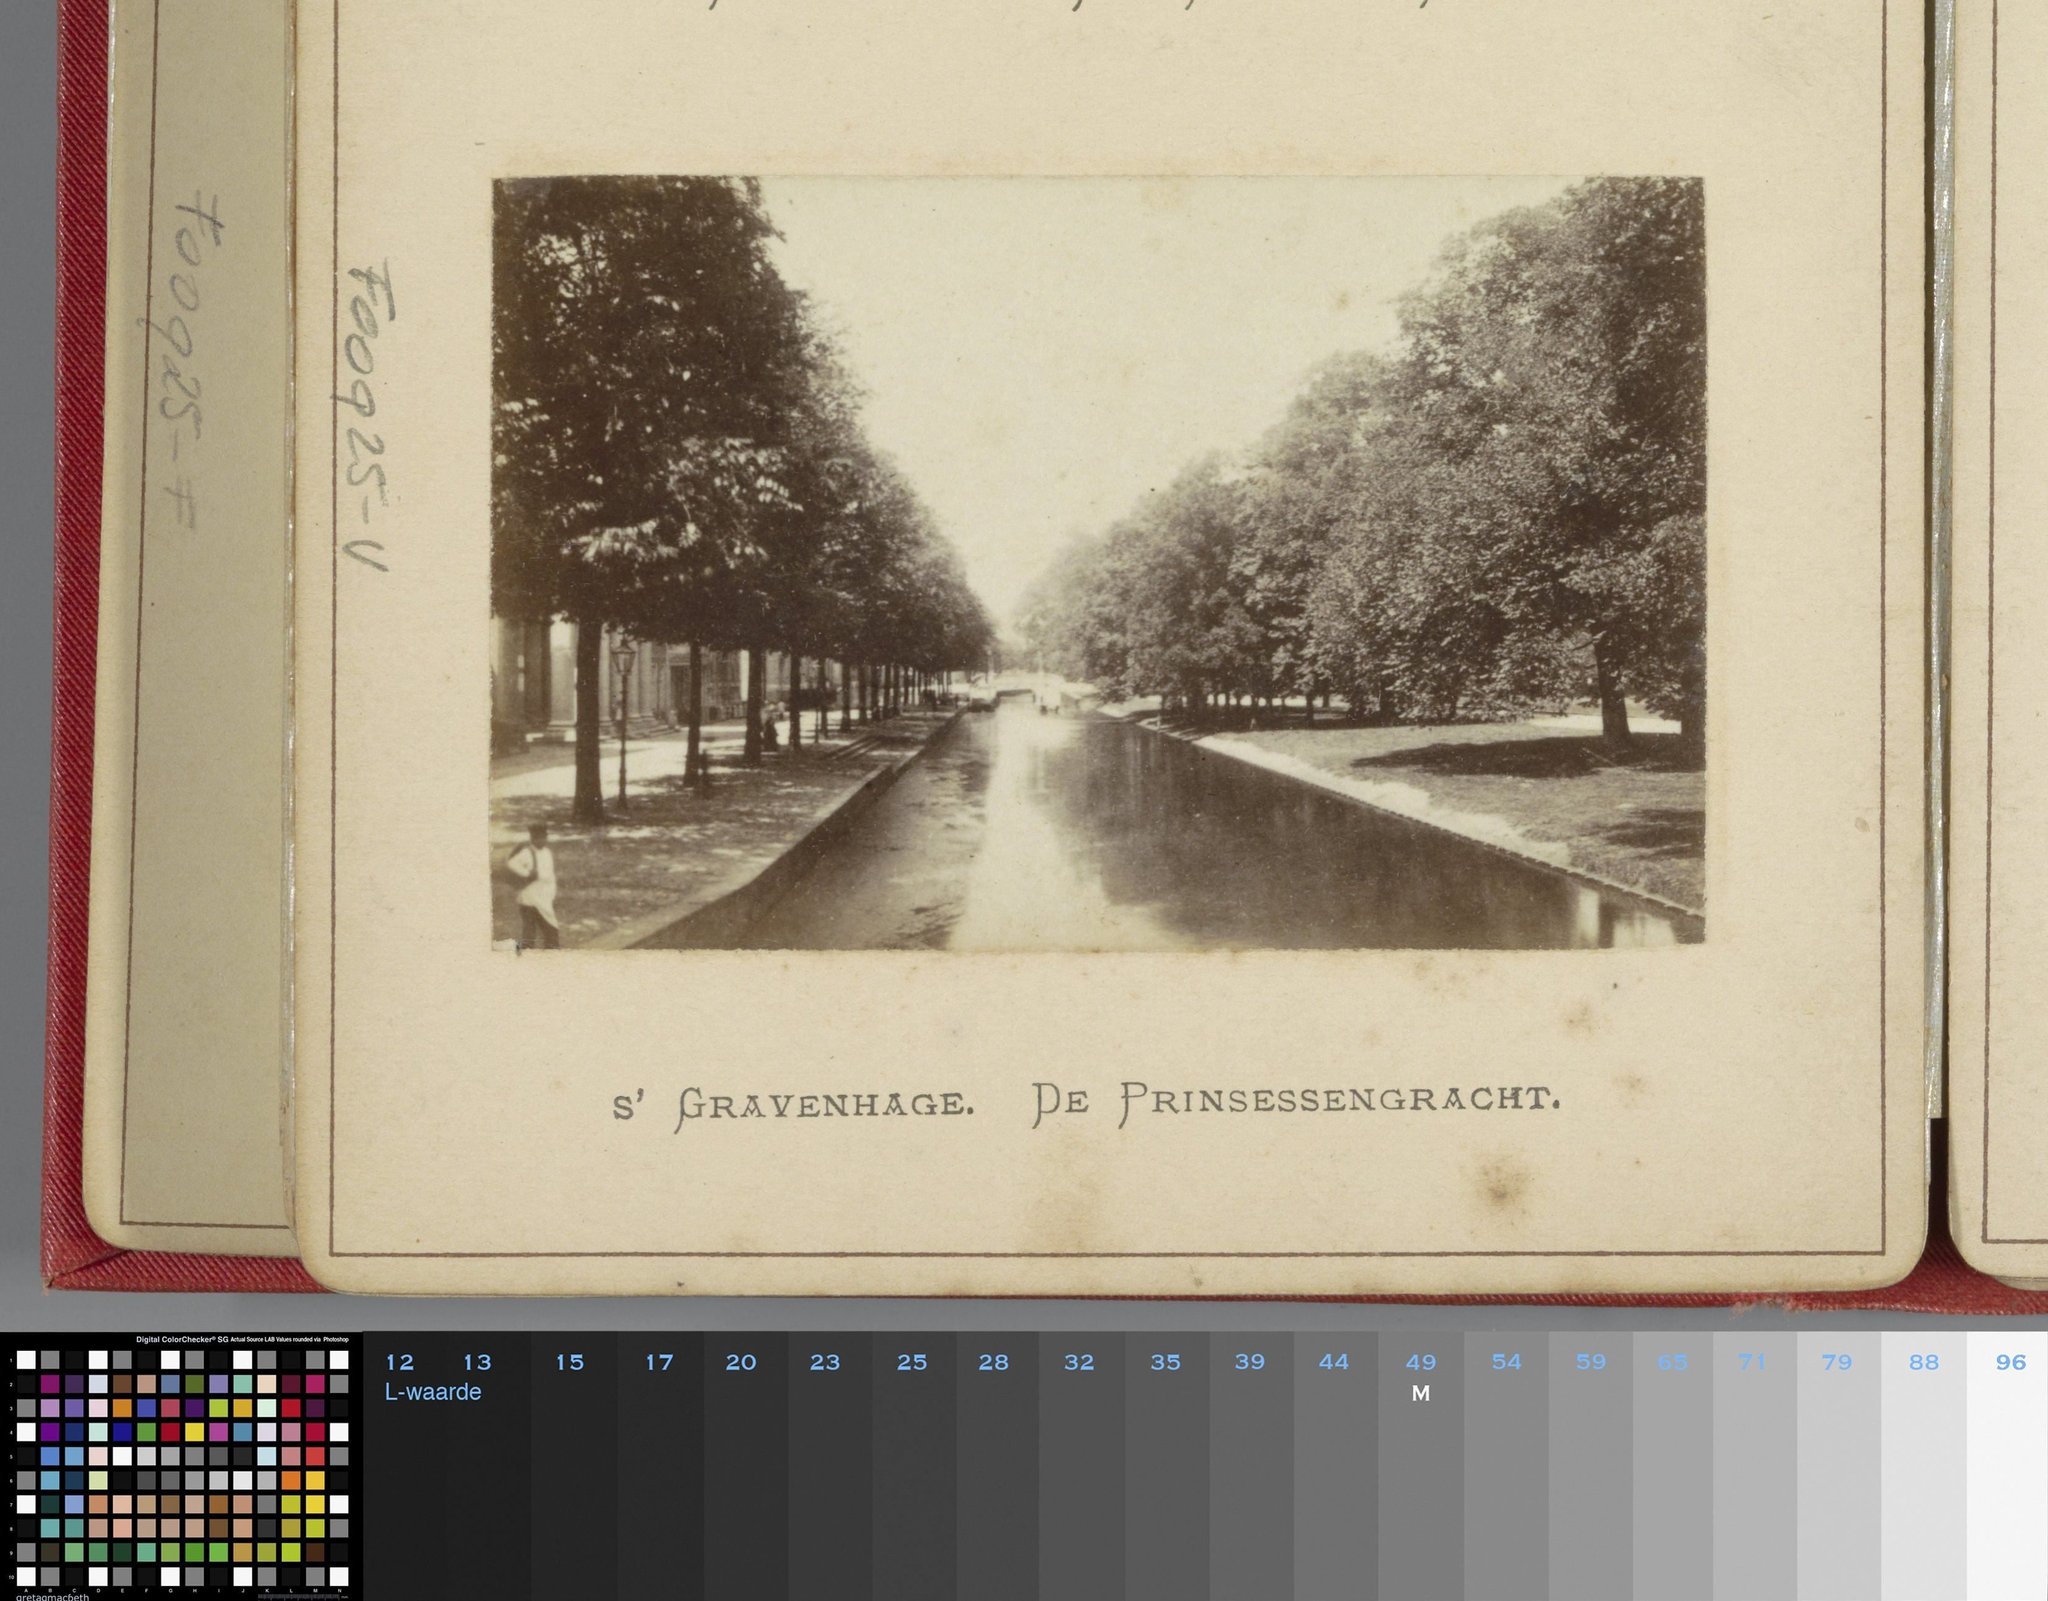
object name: photograph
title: Gezicht op Prinsessegracht in Den Haag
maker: andries jager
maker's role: publisher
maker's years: 1825-1905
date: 1860-1900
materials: cardboard, photographic support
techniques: albumen print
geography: the hague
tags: canal, the hague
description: Onderdeel van Fotoalbum met opnames van steden in Noord- en Zuid-Holland en Utrecht.